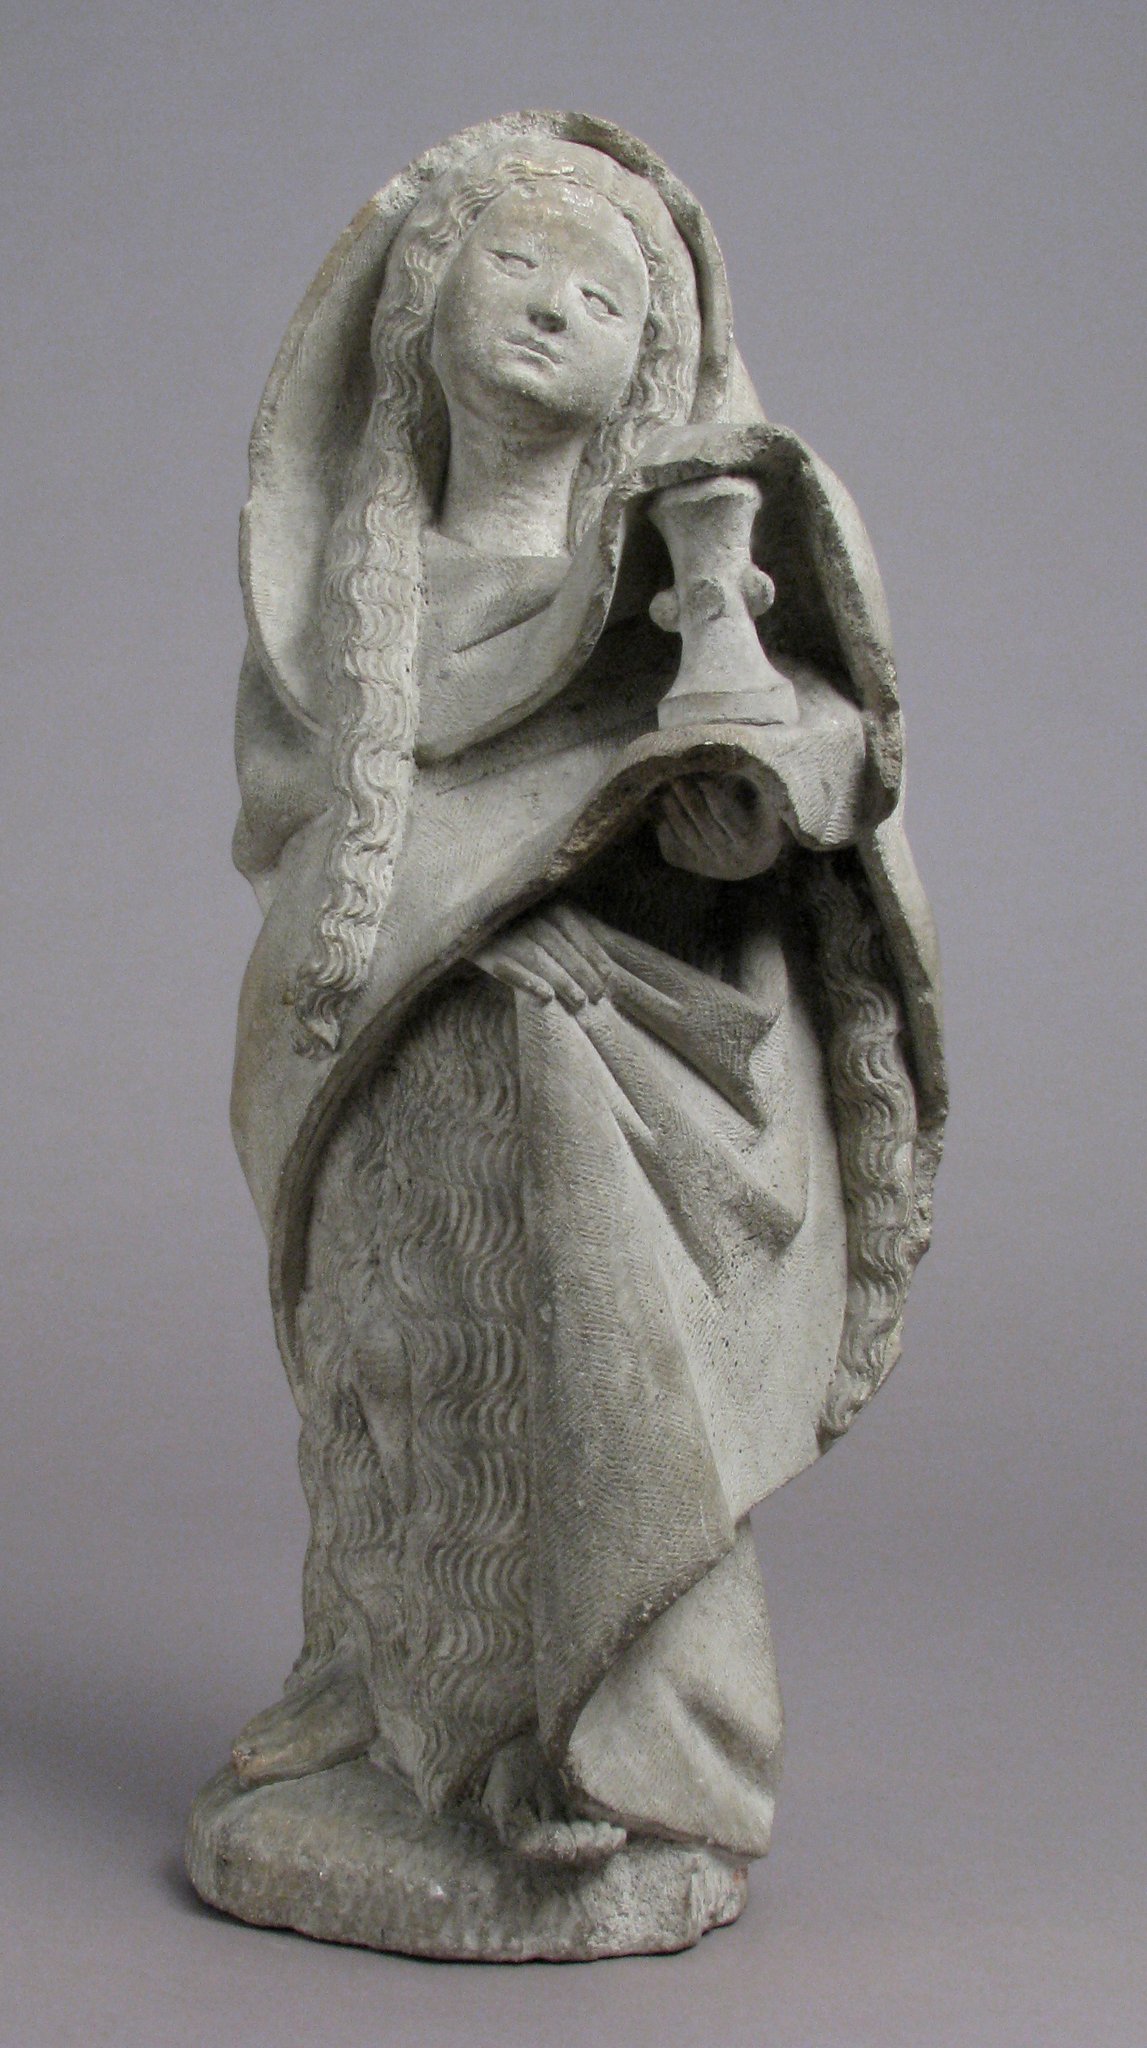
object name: statuette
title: Saint Mary Magdalene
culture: french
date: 1401-1500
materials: limestone